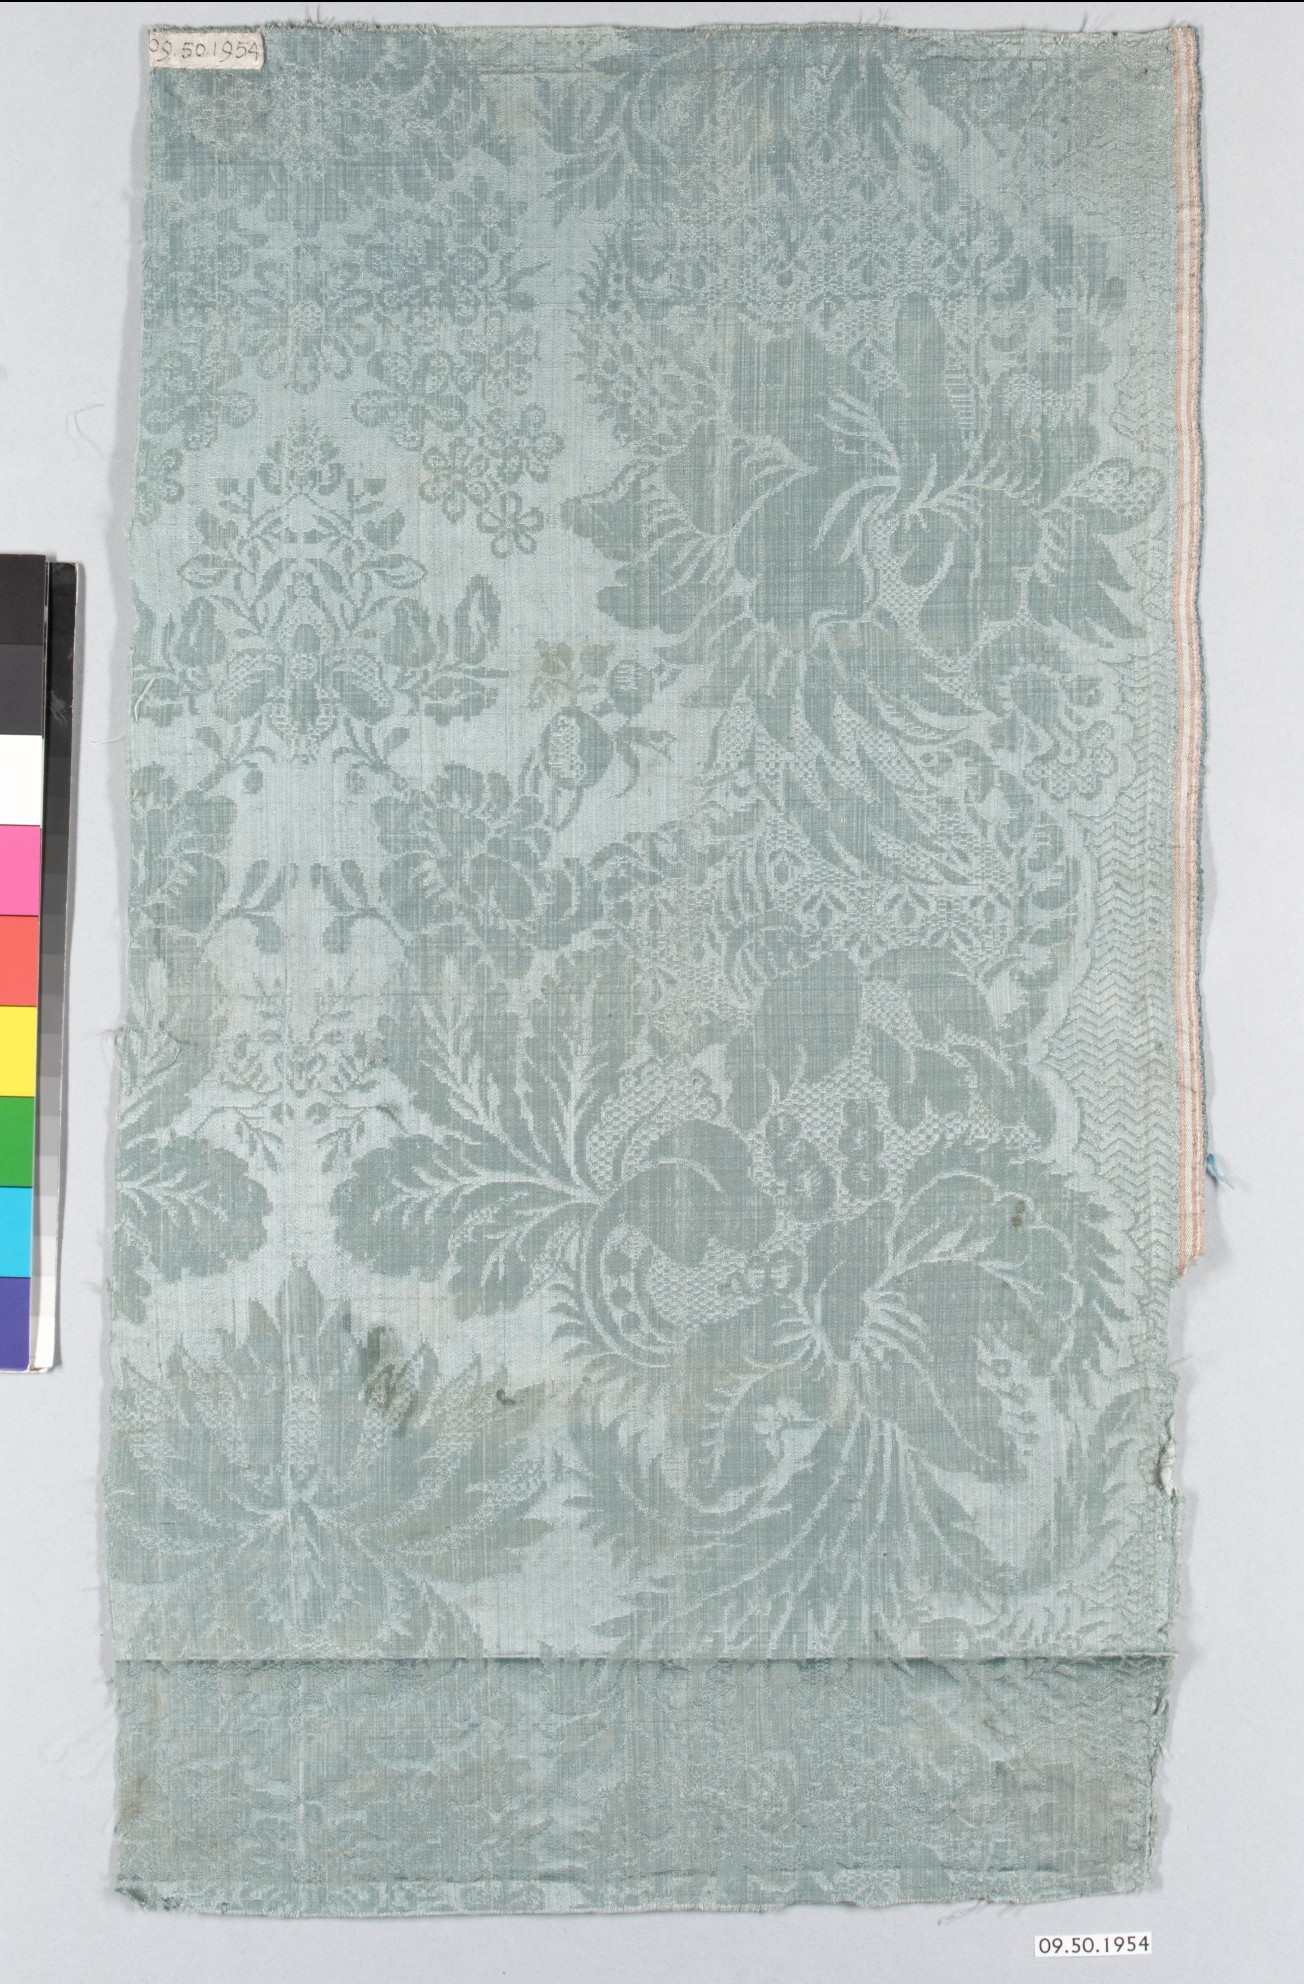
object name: piece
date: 1725-1730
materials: silk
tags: flowers,leaves